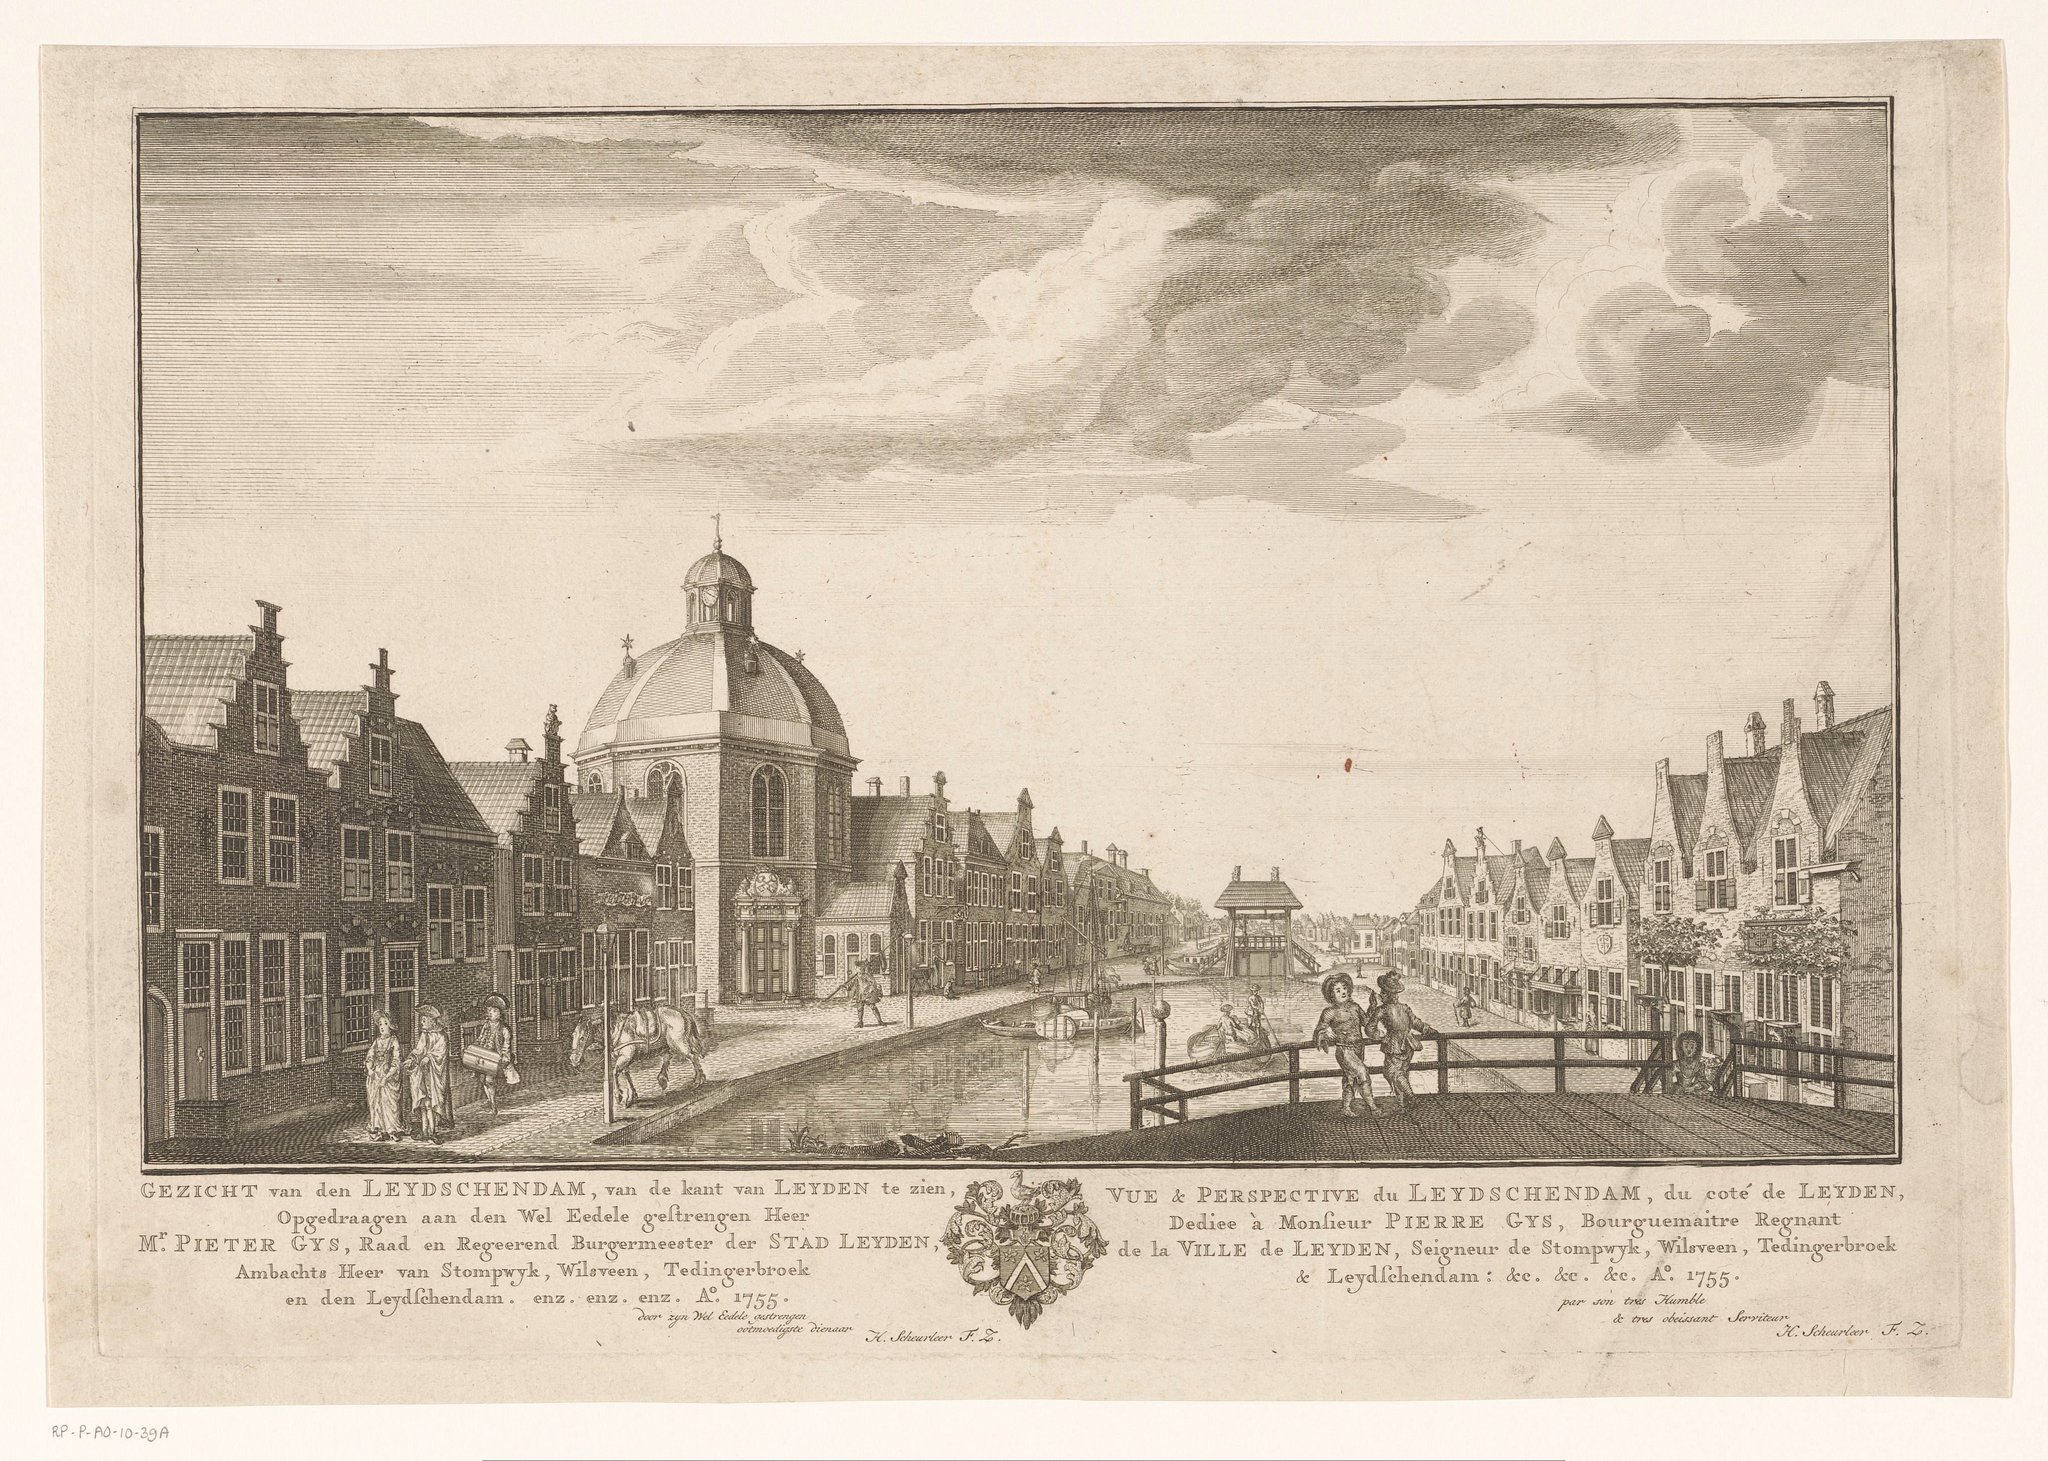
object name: print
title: Achttien gezichten in en om Den Haag (Besoet / Scheurleer)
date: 1755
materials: paper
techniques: engraving, etching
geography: the hague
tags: prospect of village, silhouette of village, dam (in canal), armorial bearing, heraldry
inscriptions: collector's mark: Lugt 195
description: Gezicht op de Leidse Dam te Leidschendam, gelegen aan de Vliet tussen Leiden en Delft, gezien vanuit de richting van Leiden. Onder de voorstelling de titel en opdracht in het Nederlands en Frans, met in het midden het familiewapen van de Leidse burgemeester Pieter Gijs. Prent uit een serie van achttien gezichten in en om Den Haag.